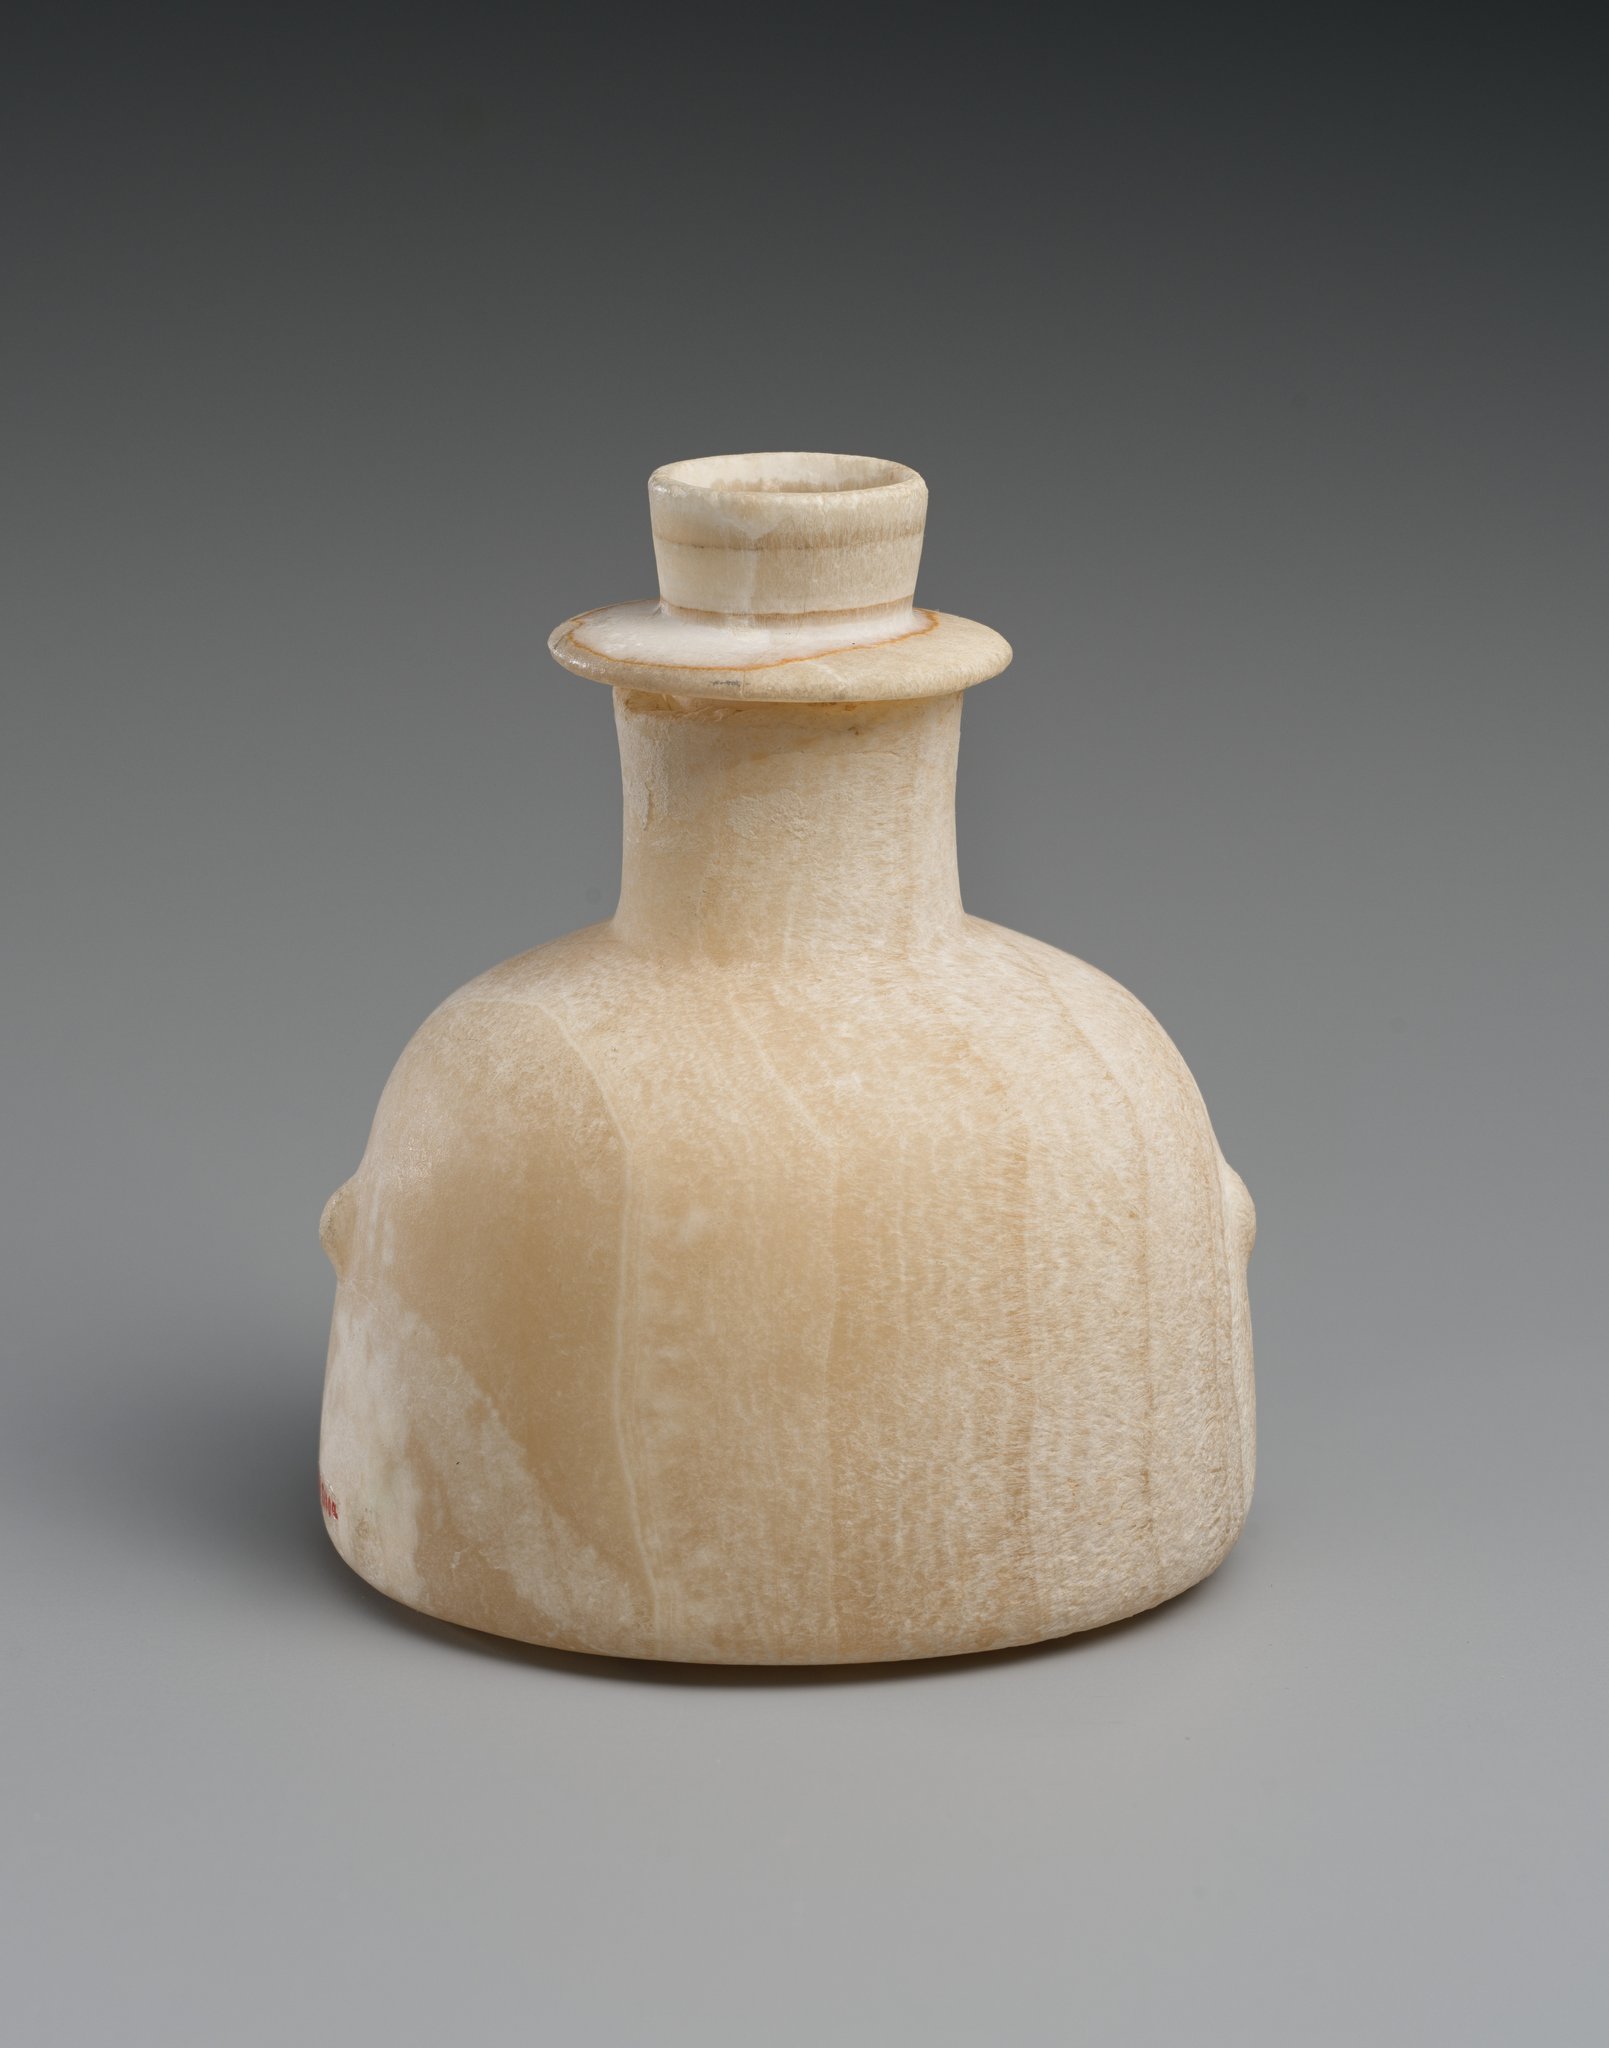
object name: flask with stopper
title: Alabaster flask with stopper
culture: cypriot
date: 200-68 BCE